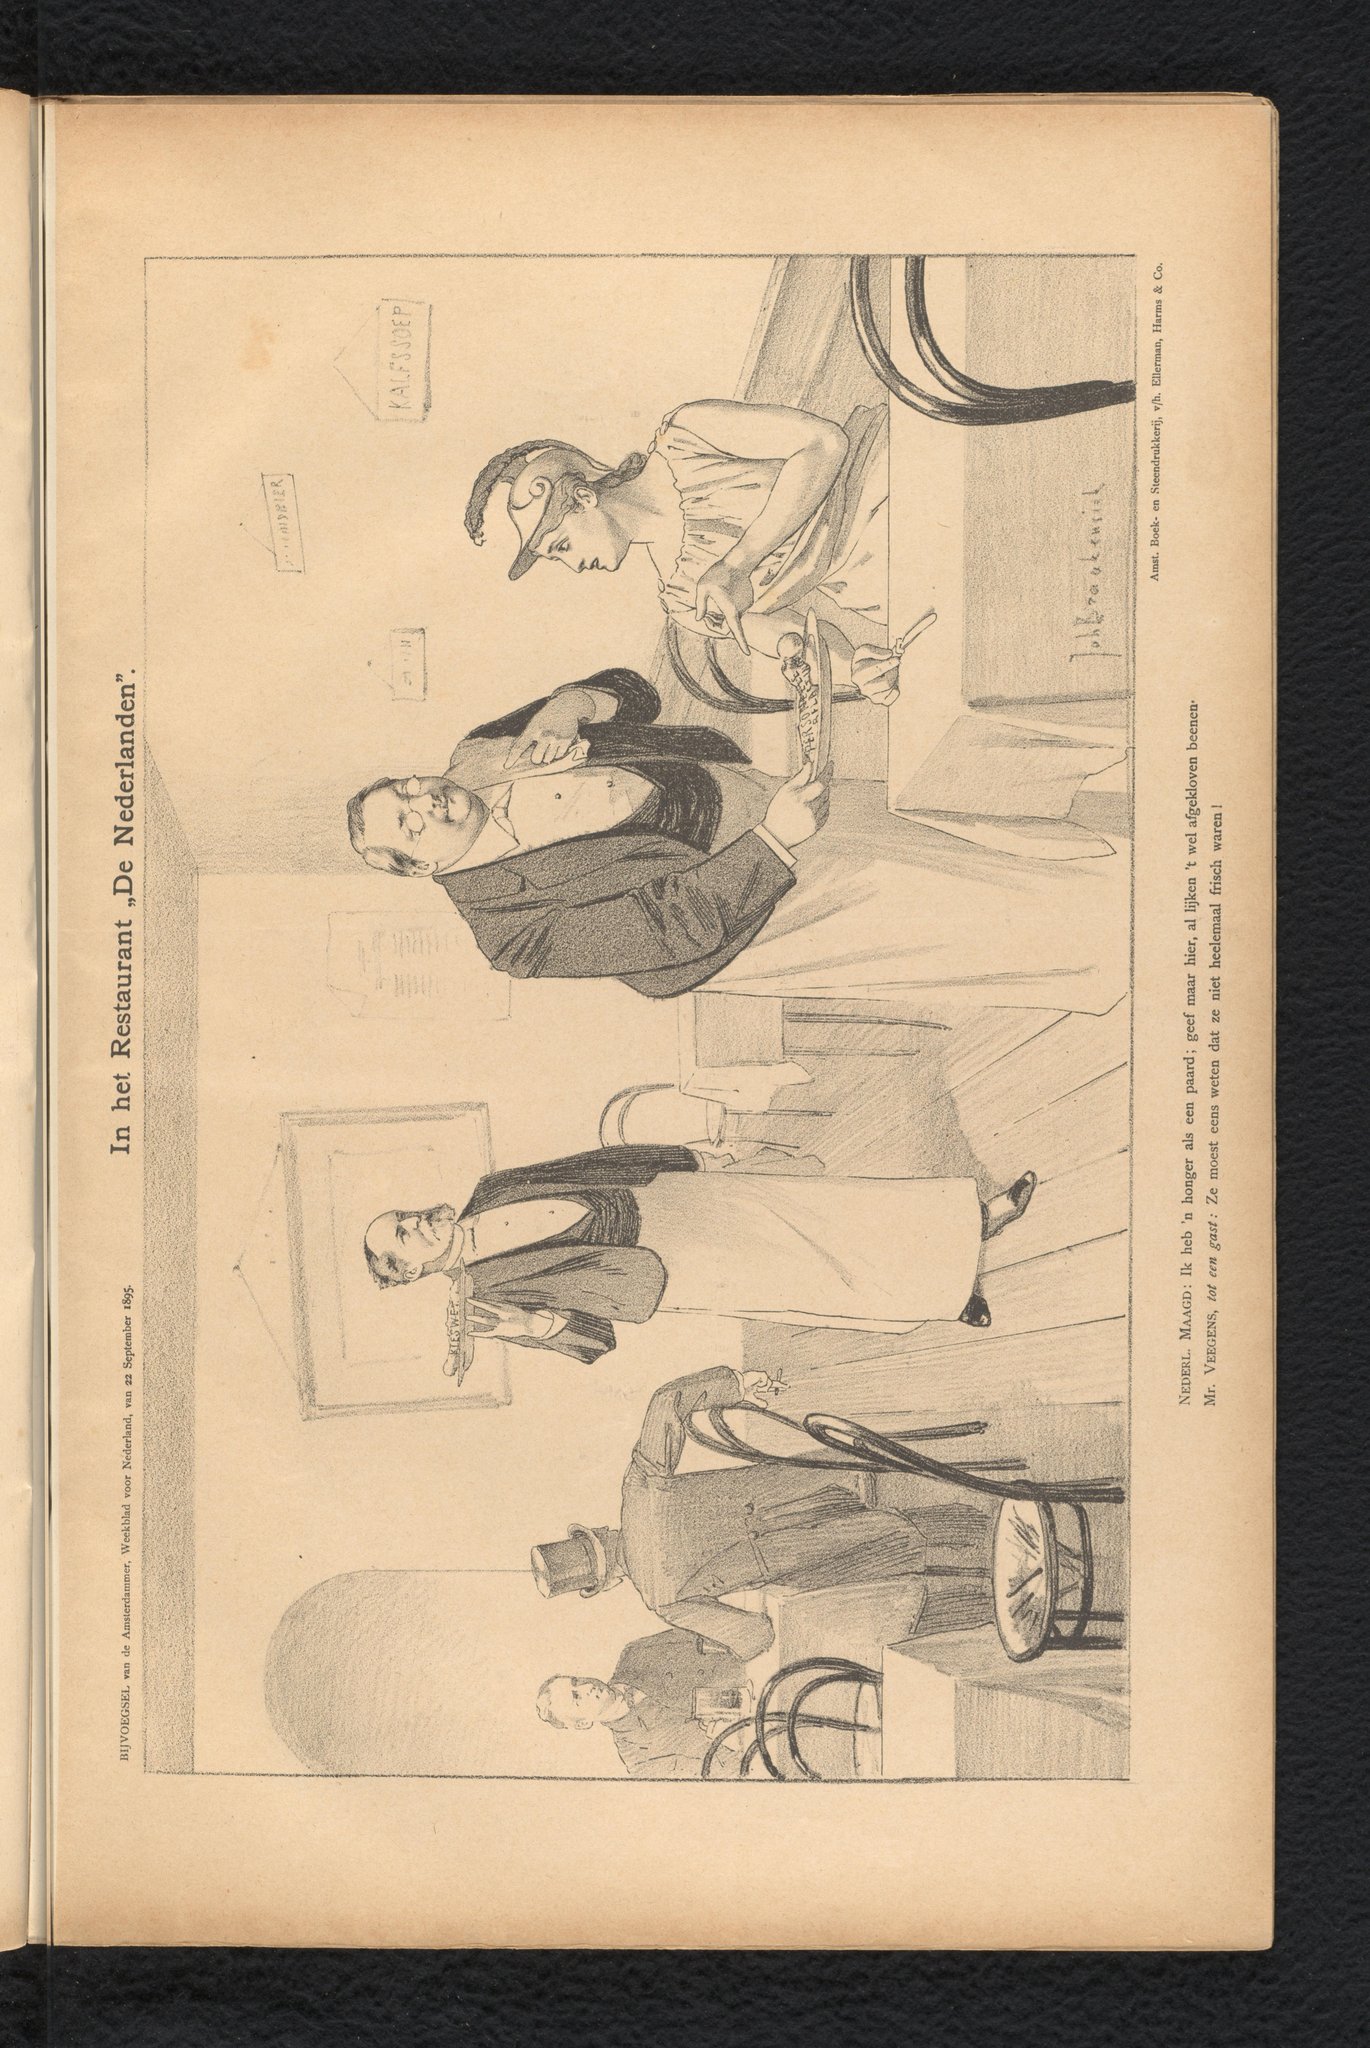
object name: cartoon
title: In het Restaurant "De Nederlanden"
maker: johan braakensiek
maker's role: draughtsman, print maker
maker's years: 1858-1940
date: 1895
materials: paper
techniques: lithograph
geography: amsterdam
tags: the hague, samuel van houten, personifications of countries, nations, states, districts, etc., restaurant (+ waiter, waitress, etc.), restaurant, political caricatures and satires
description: De Nederlandse Maagd wordt in het restaurant "De Nederlanden" oude kliekjes geserveerd door de ministers Van Houten en Sprenger van Eyk. Met twee andere gasten, waaronder Jacob Dirk Veegens.